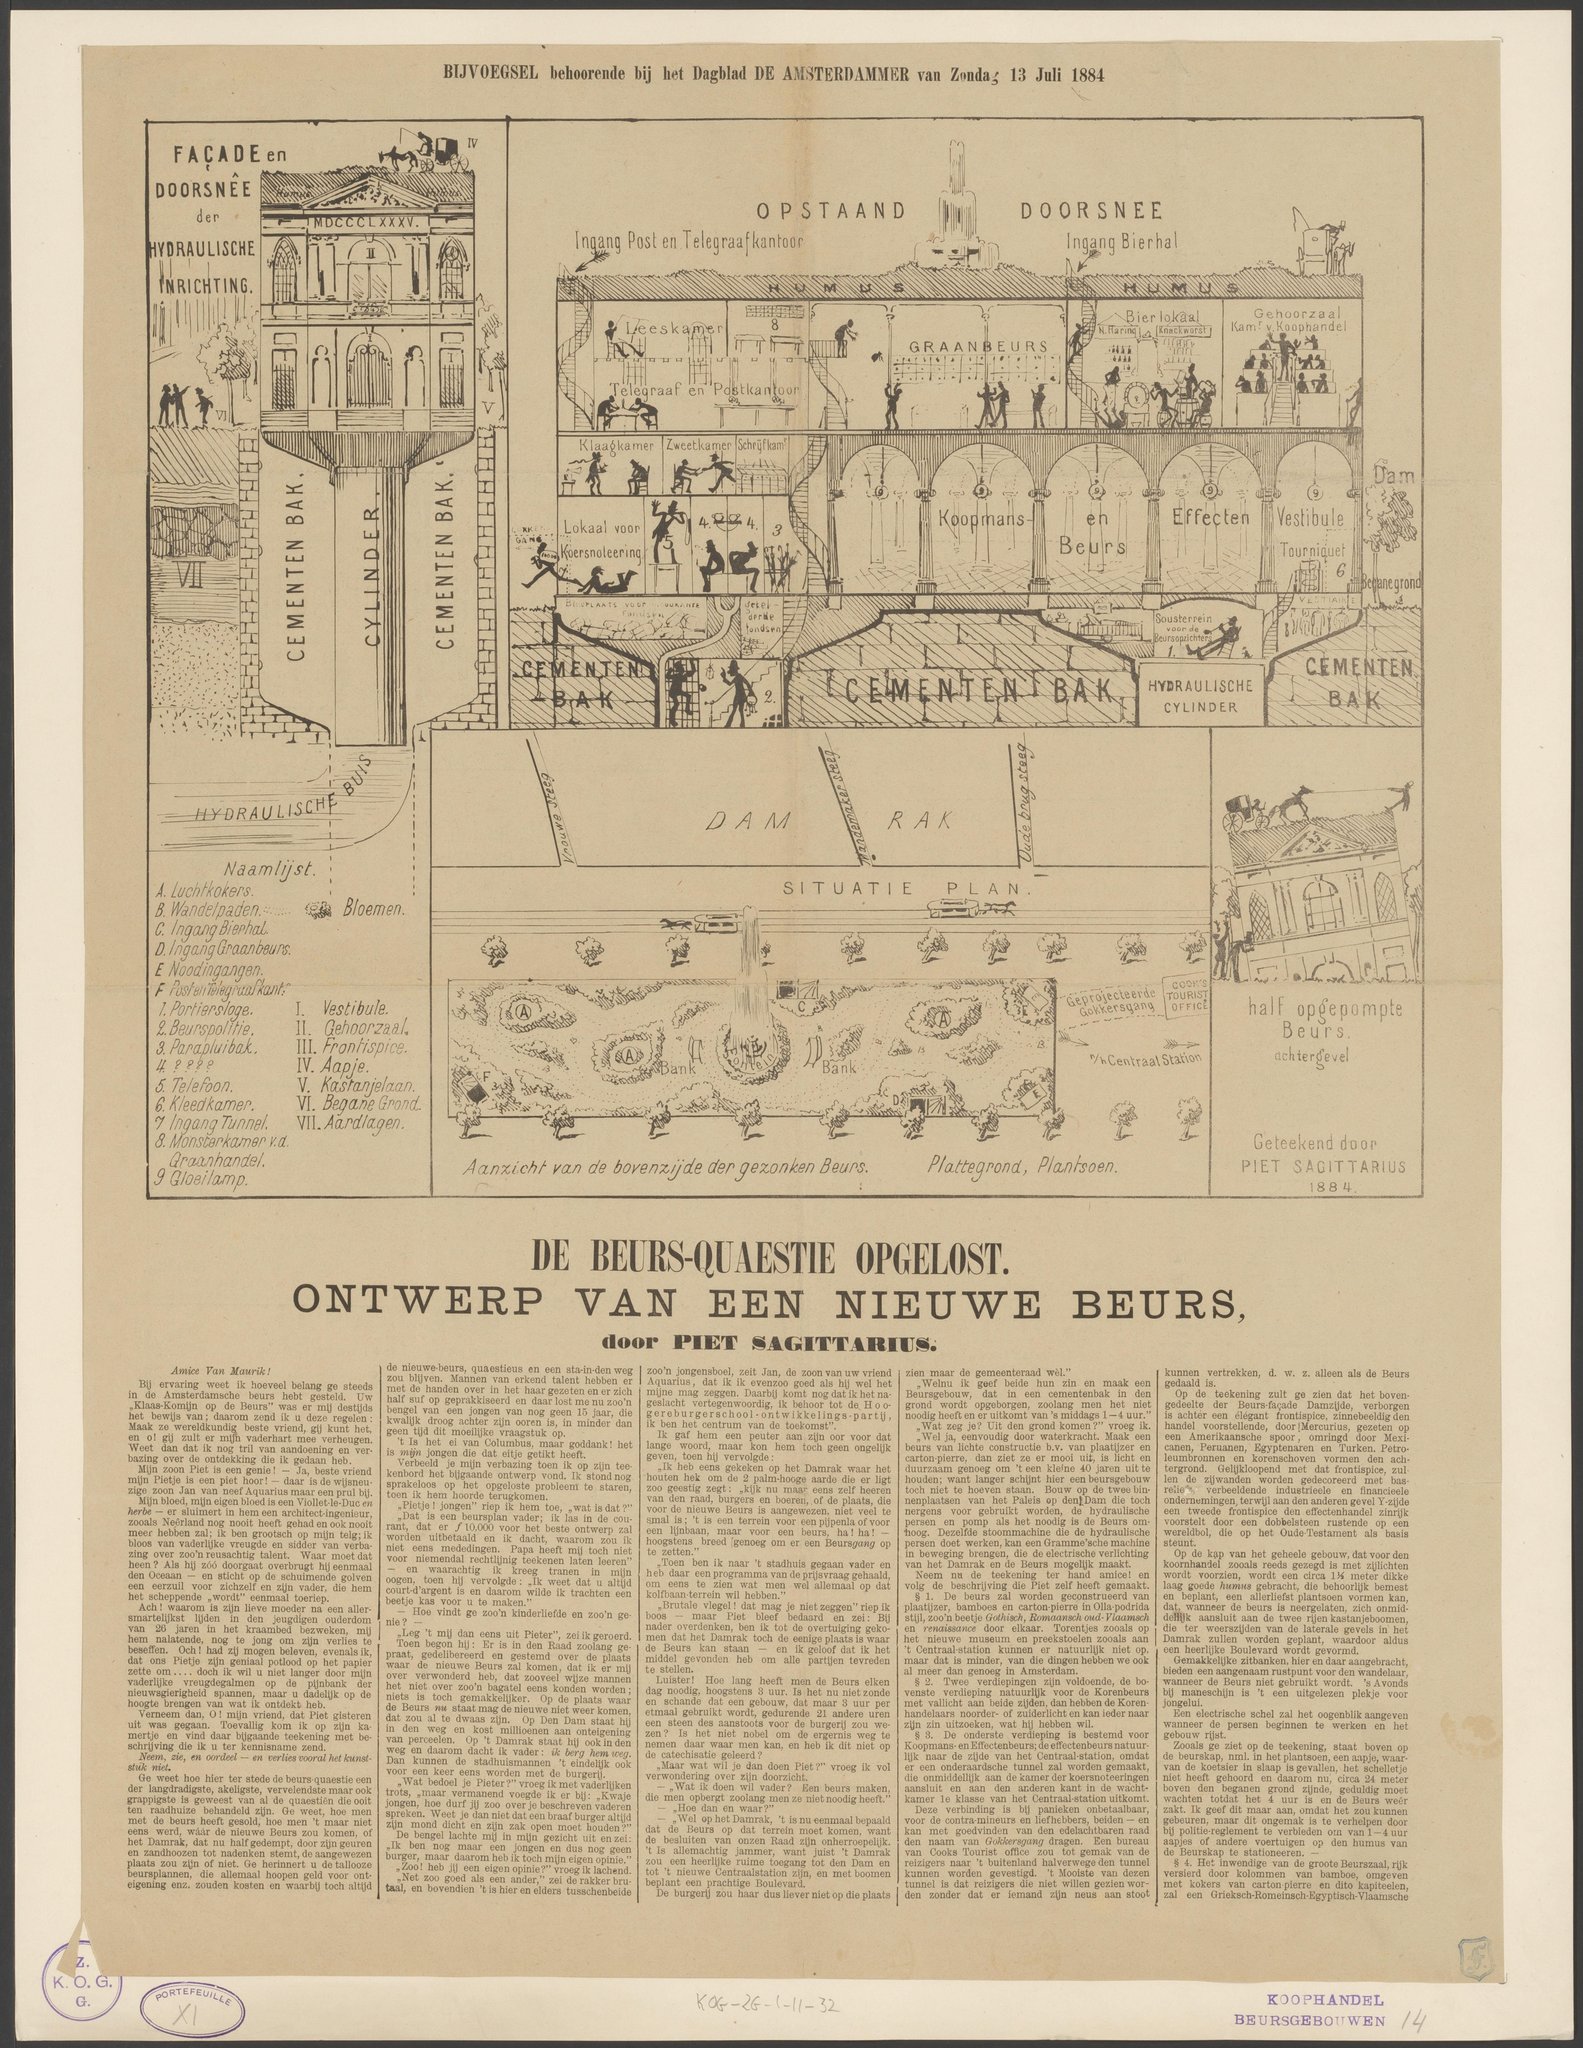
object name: text sheet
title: De beurs-quaestie opgelost. Ontwerp van een nieuwe beurs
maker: Anonymous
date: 1884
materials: paper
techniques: letterpress printing, lithograph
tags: stock exchange, stock-market, amsterdam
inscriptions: stamp, collector's mark: Lugt 1641, stamp, collector's mark: Lugt 963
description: Onderwerpsrubrieken binnen de Atlas Zeden en Gewoonten: Handel, nijverheid en verkeer, Koophandel, Beursgebouwen.